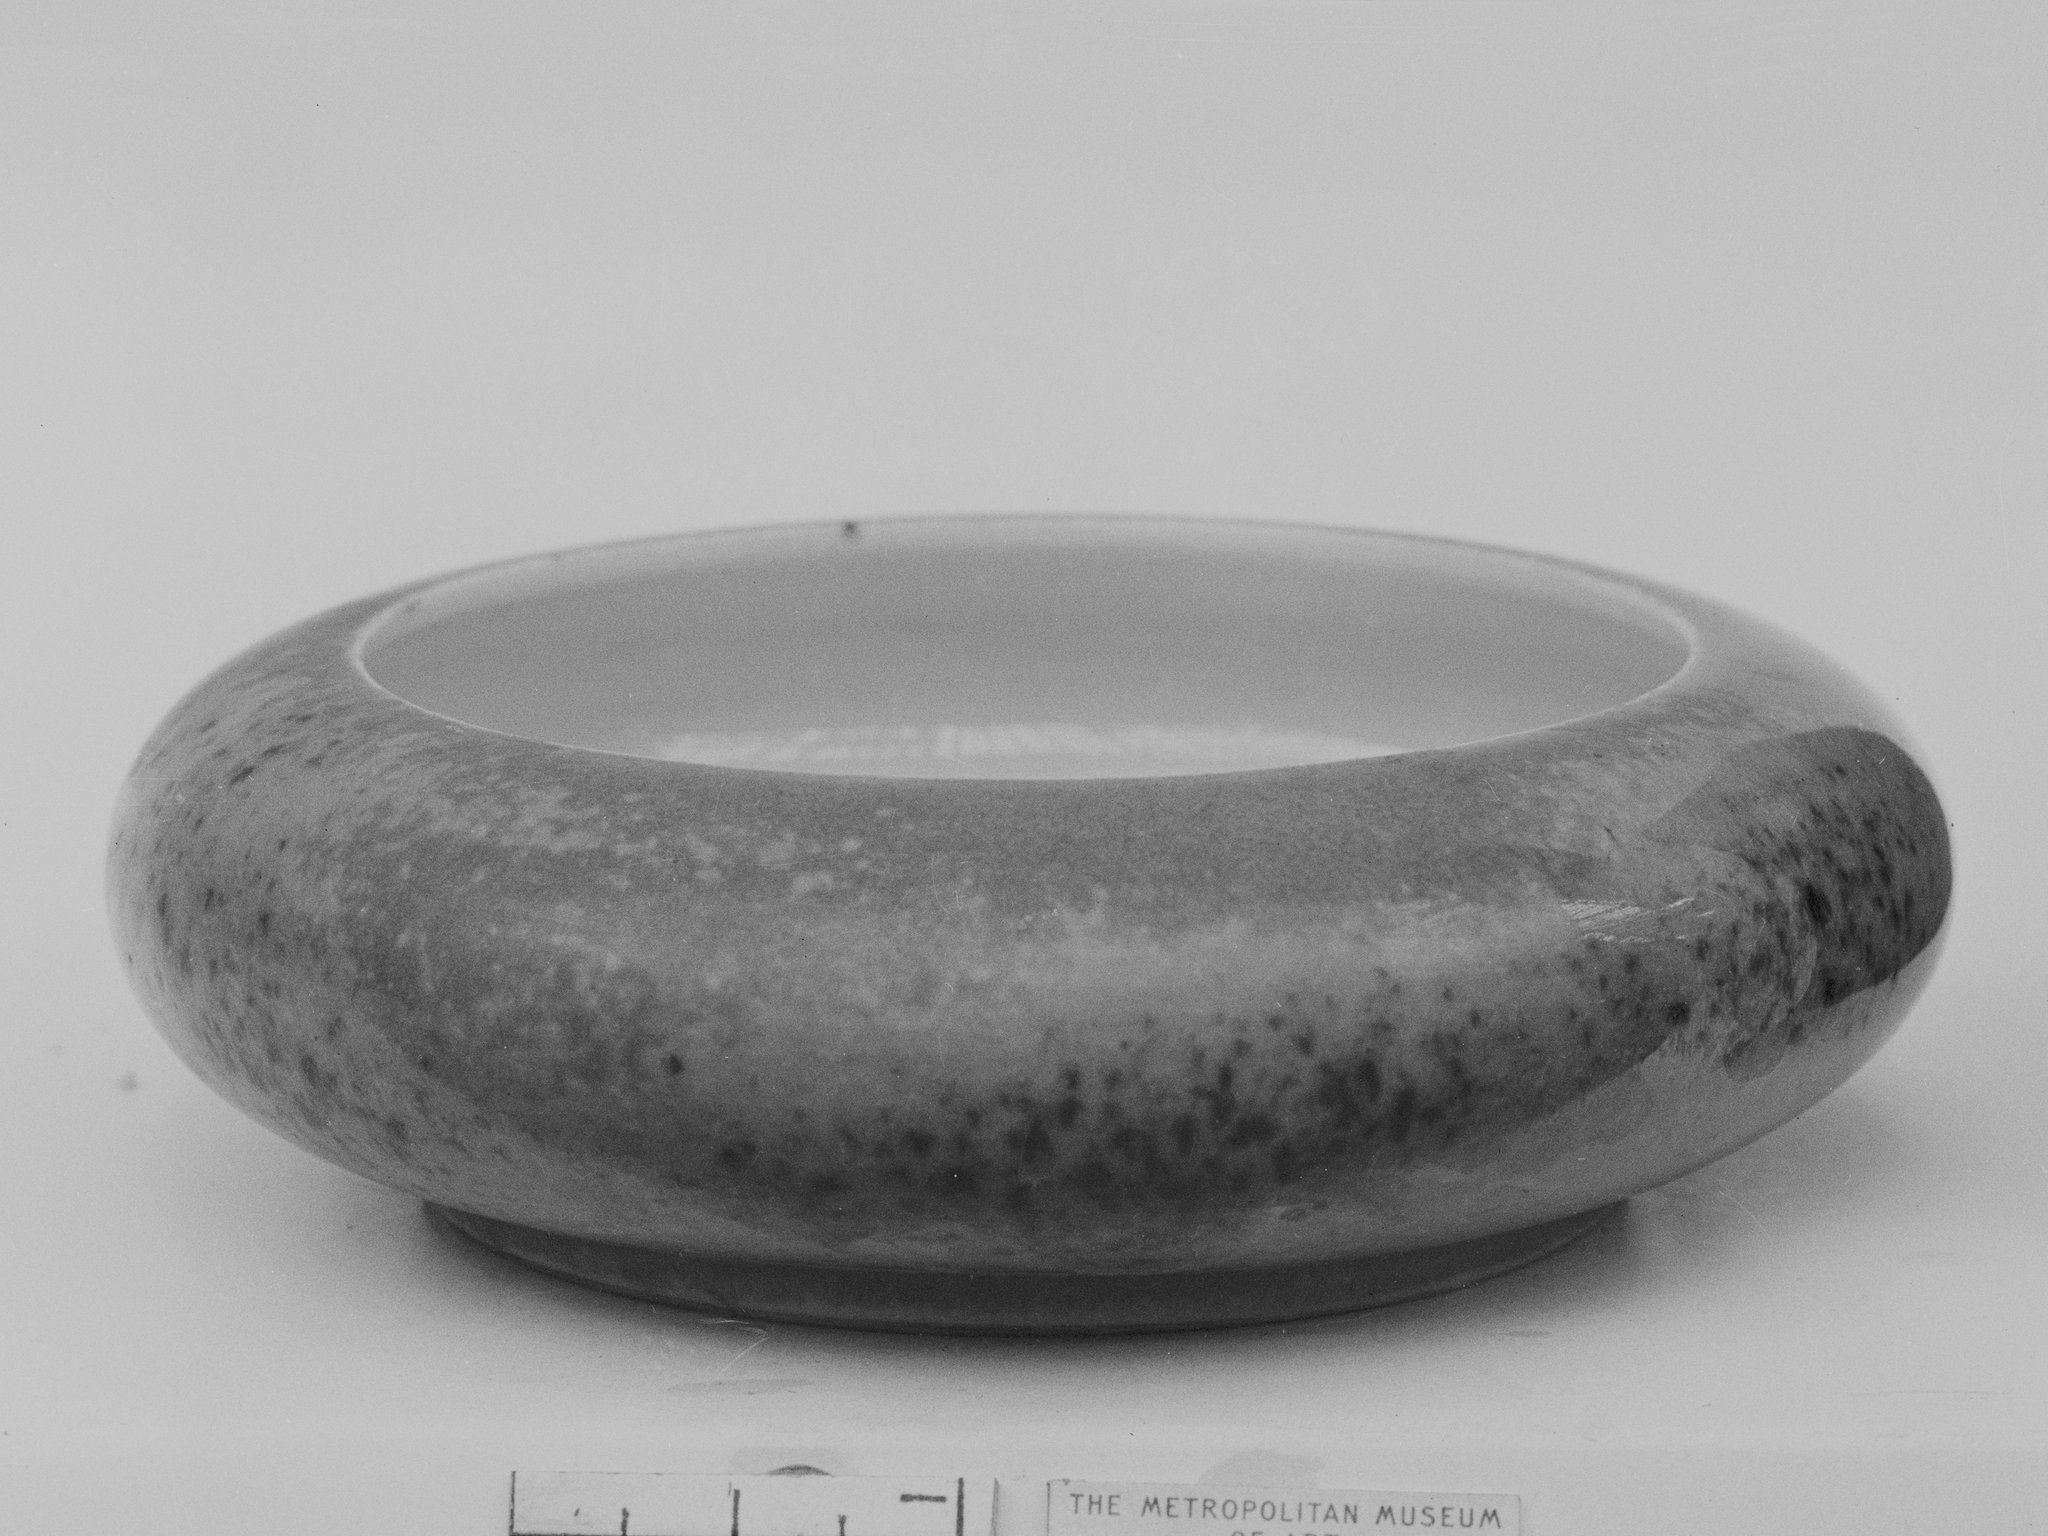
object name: brush washer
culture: chinese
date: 1601-1800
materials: glaze, porcelain